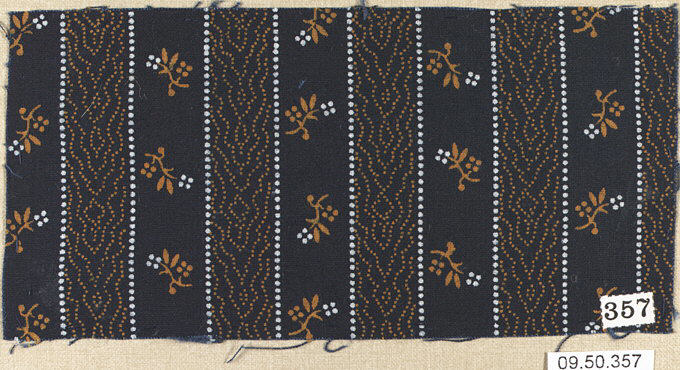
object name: piece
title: Piece (one of 116)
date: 1801-1900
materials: cotton